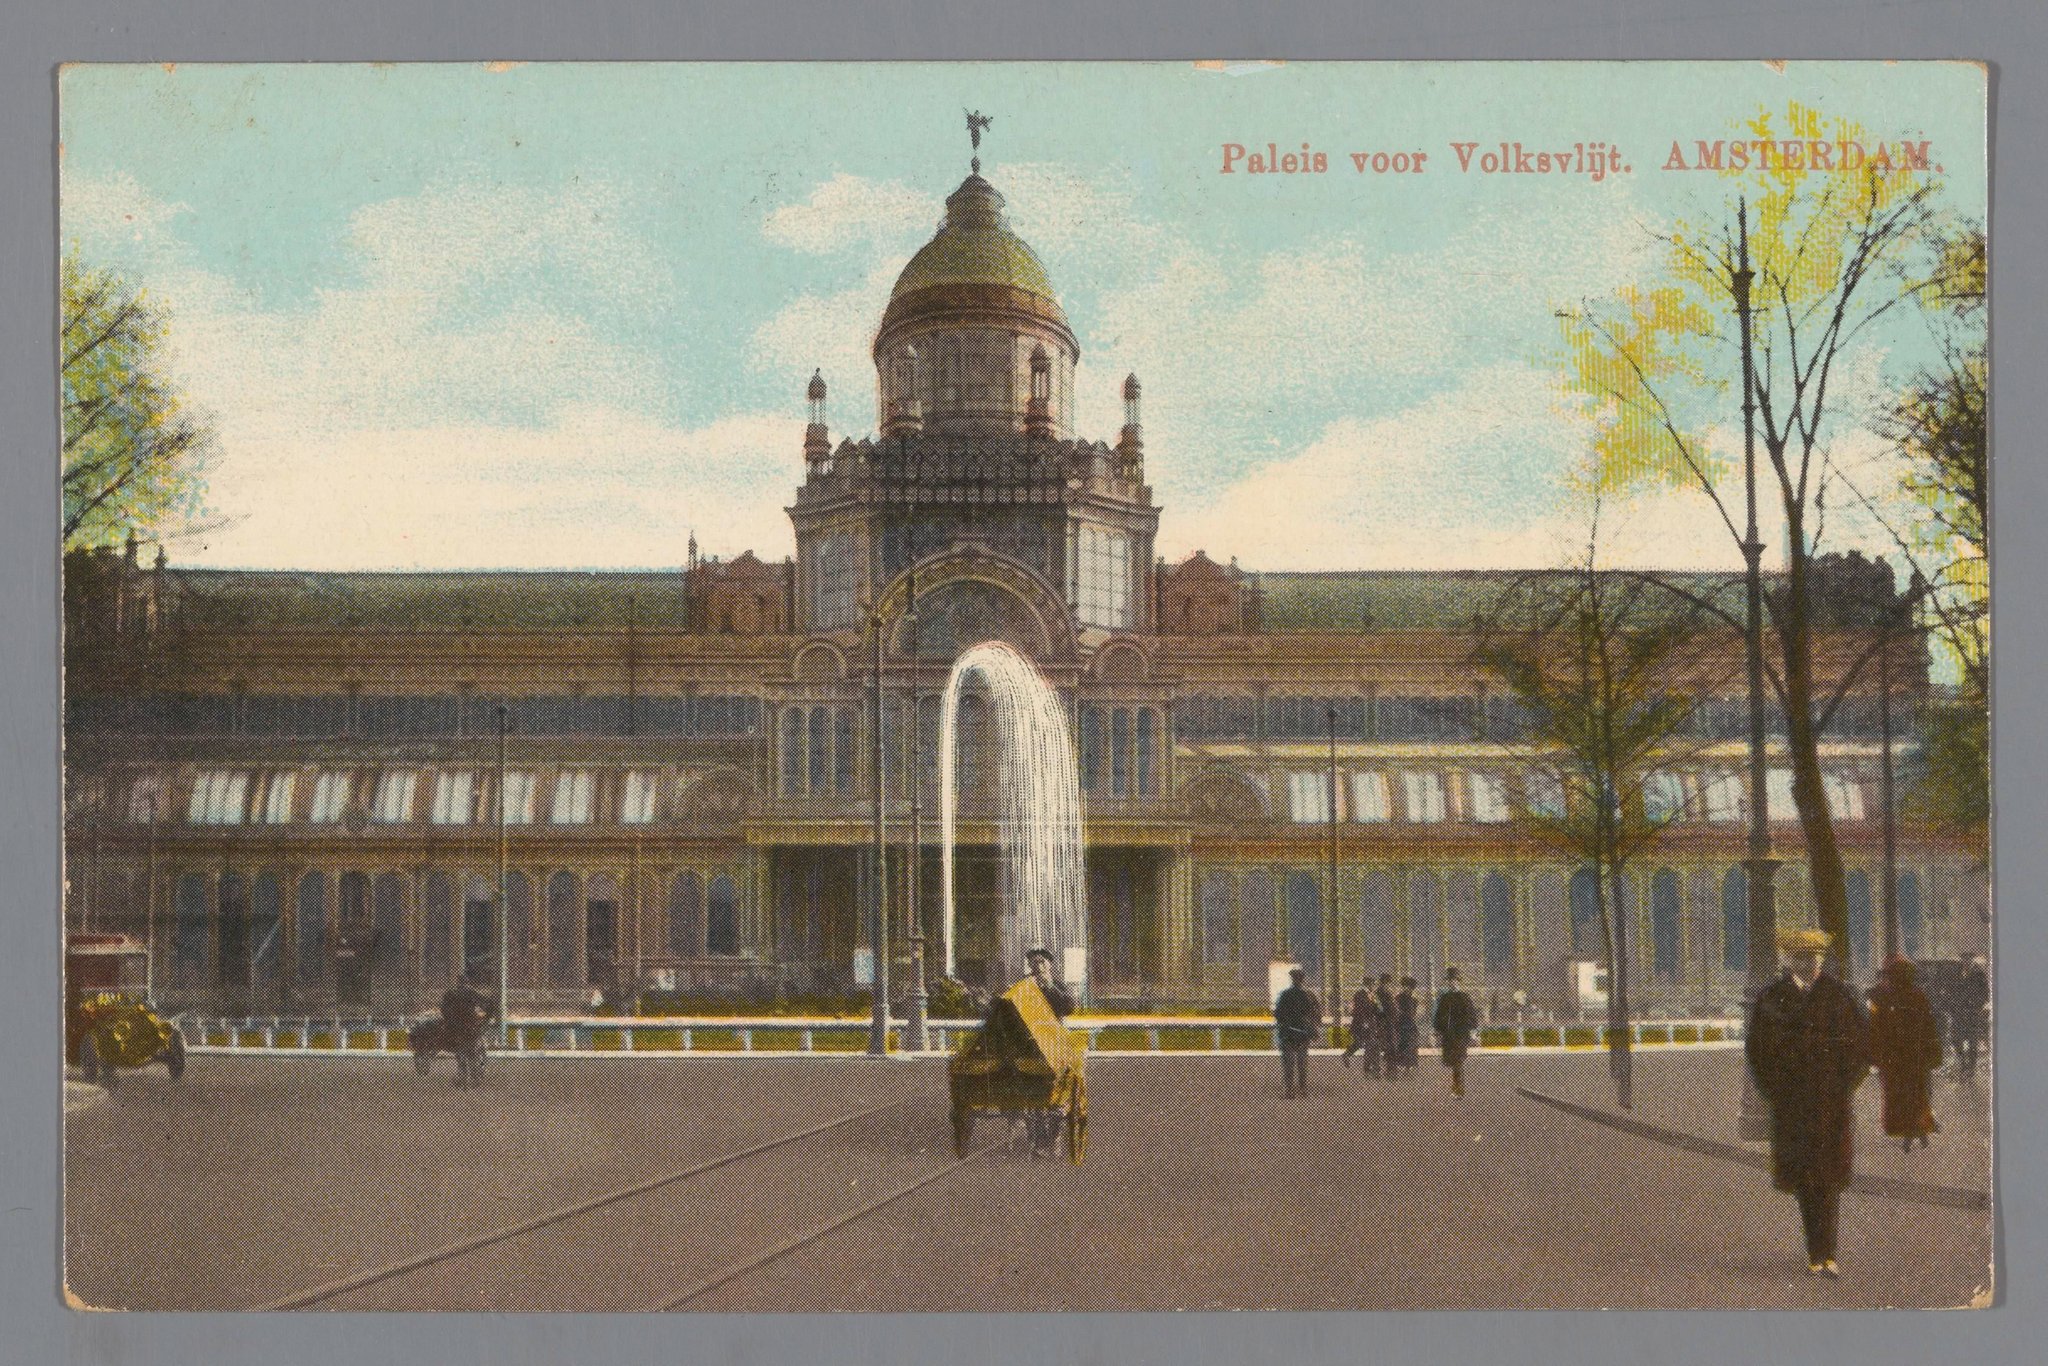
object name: photomechanical print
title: Paleis voor Volksvlijt. Amsterdam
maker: Anonymous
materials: cardboard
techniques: writing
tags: palace